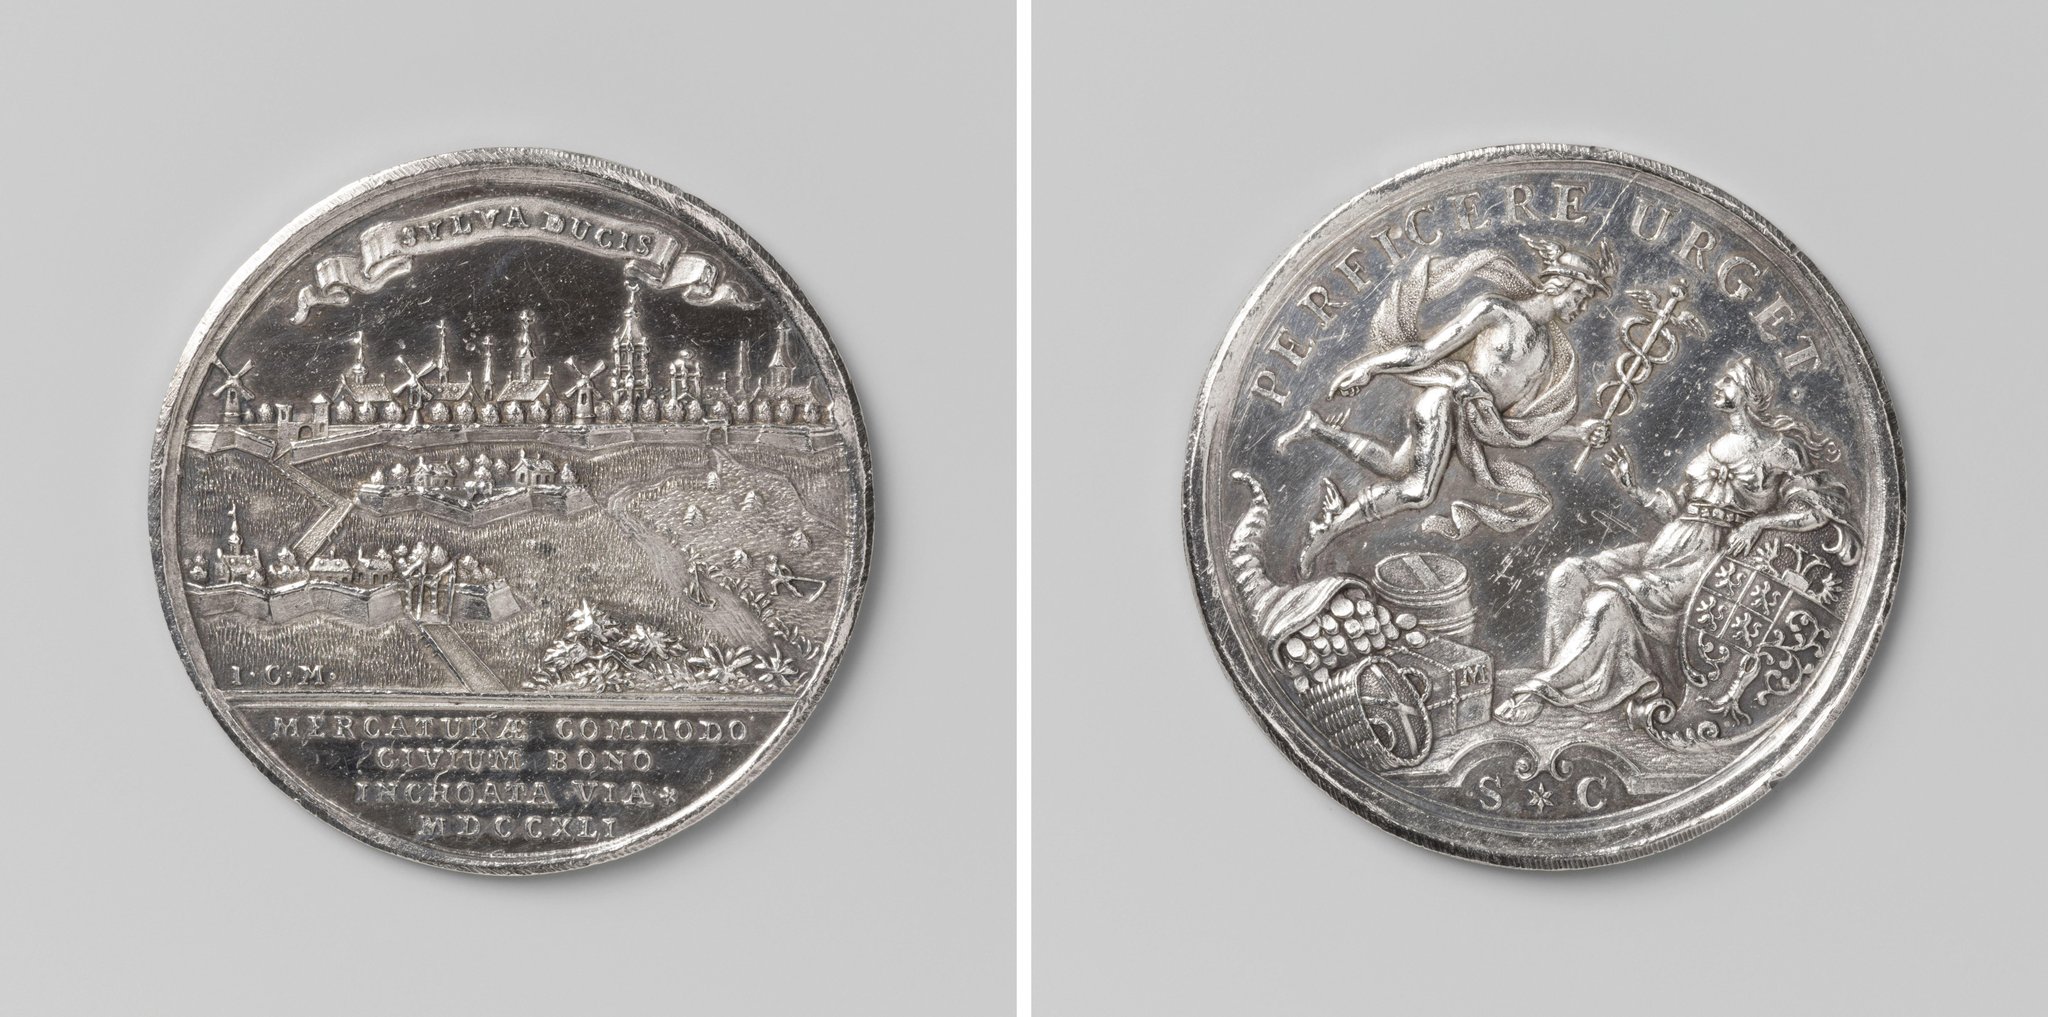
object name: council medal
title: 's-Hertogenbosch, vroedschapspenning op de aanleg van de steenweg van 's-Hertogenbosch naar Eindhoven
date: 1741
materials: silver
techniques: striking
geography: den bosch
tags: den bosch